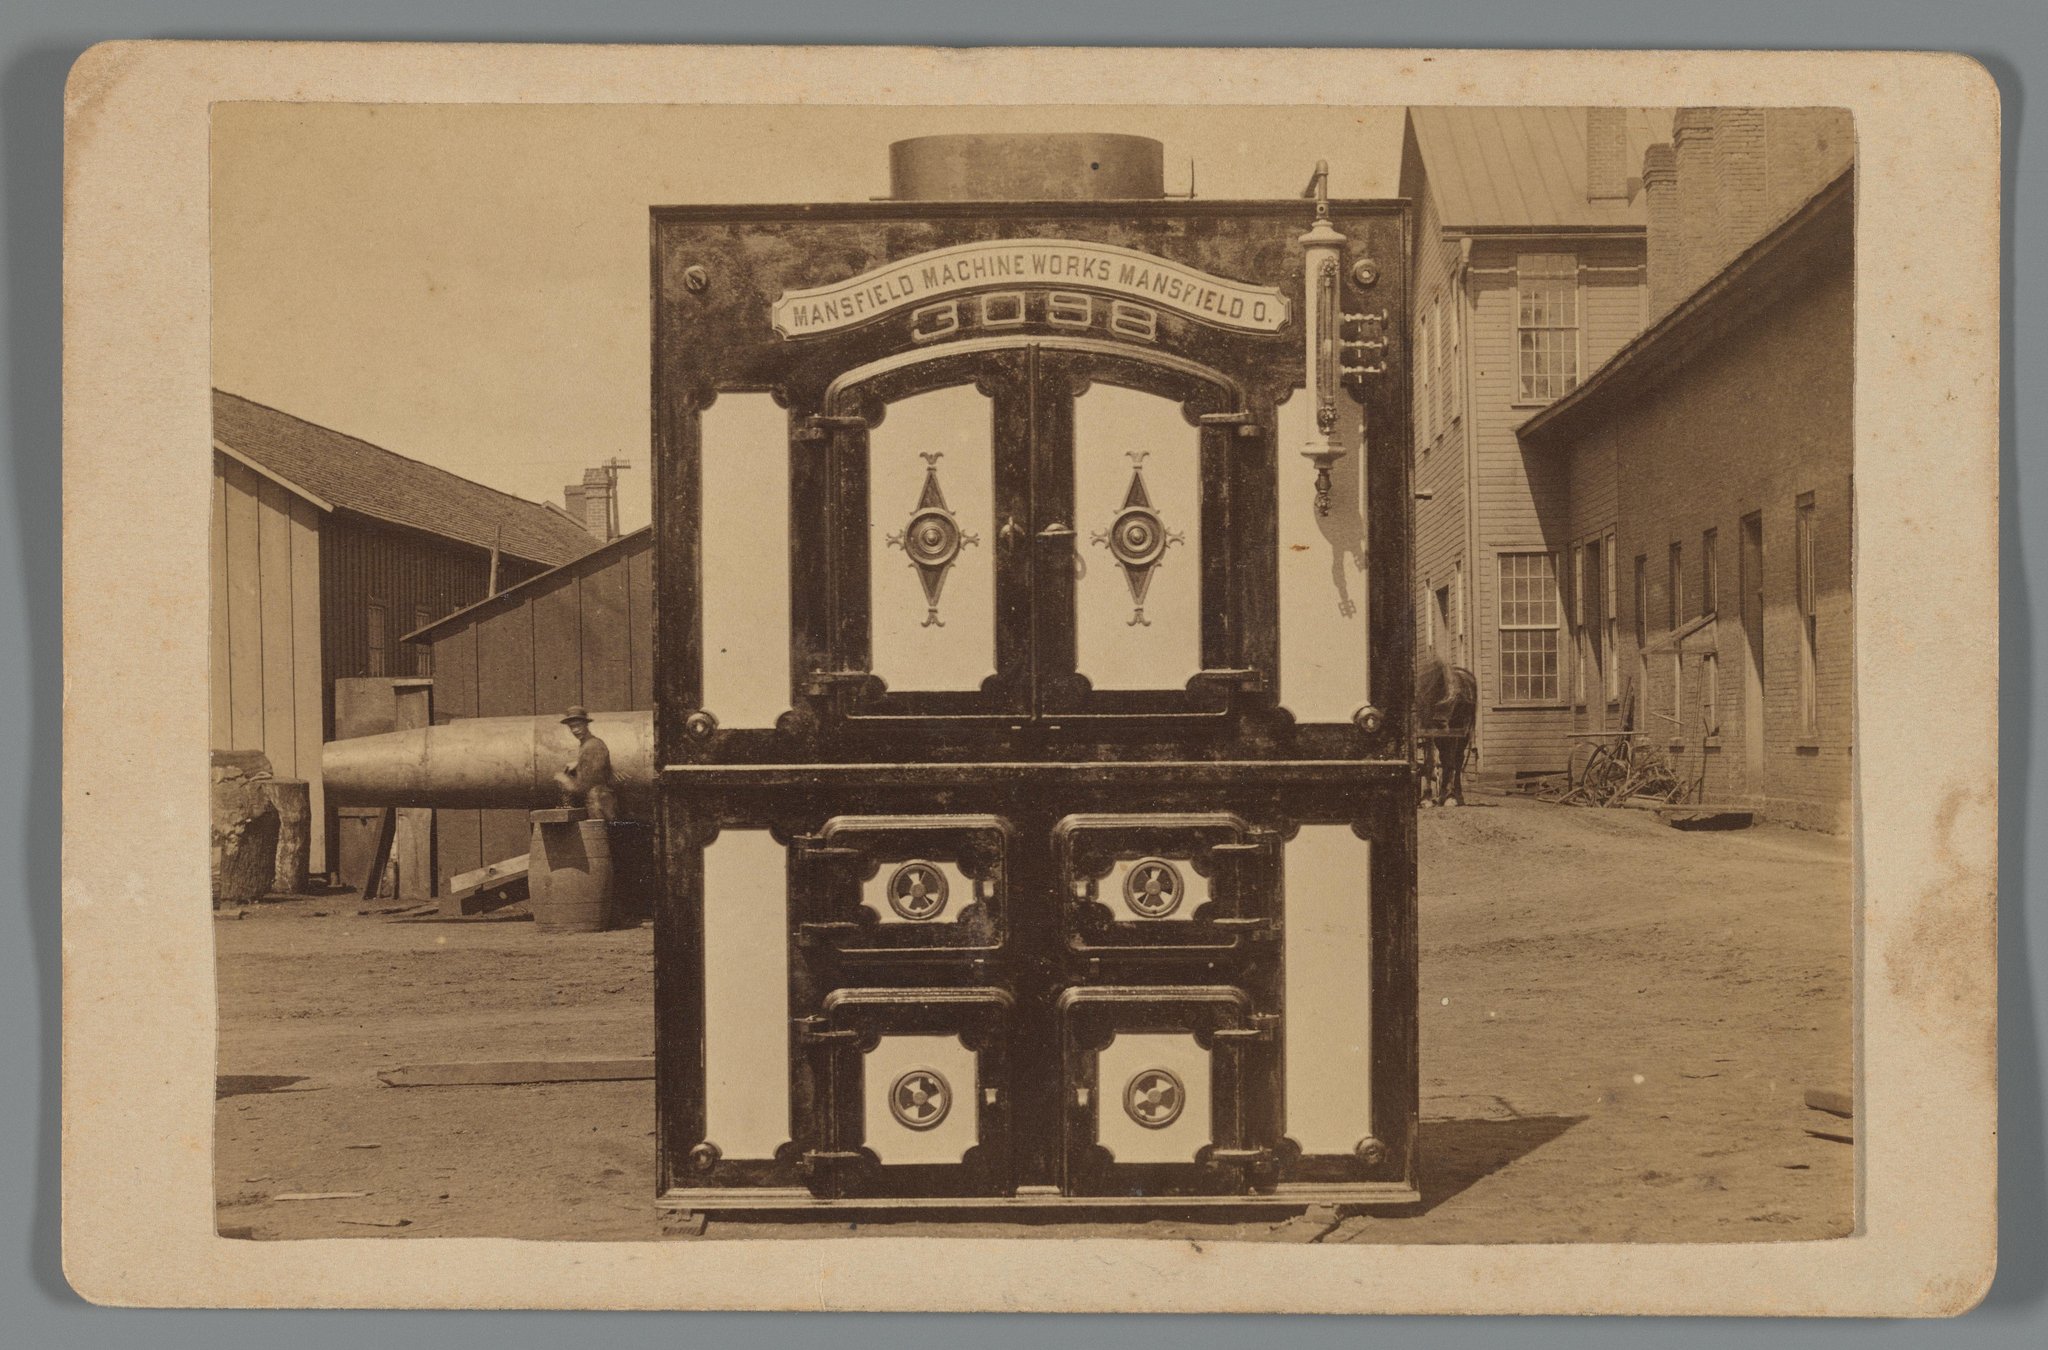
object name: cabinet photograph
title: Foto van een machine gemaakt door de Mansfield Machine Works, Mansfield, Ohio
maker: Anonymous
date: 1860-1890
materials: cardboard, paper, photographic support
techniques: albumen print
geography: mansfield